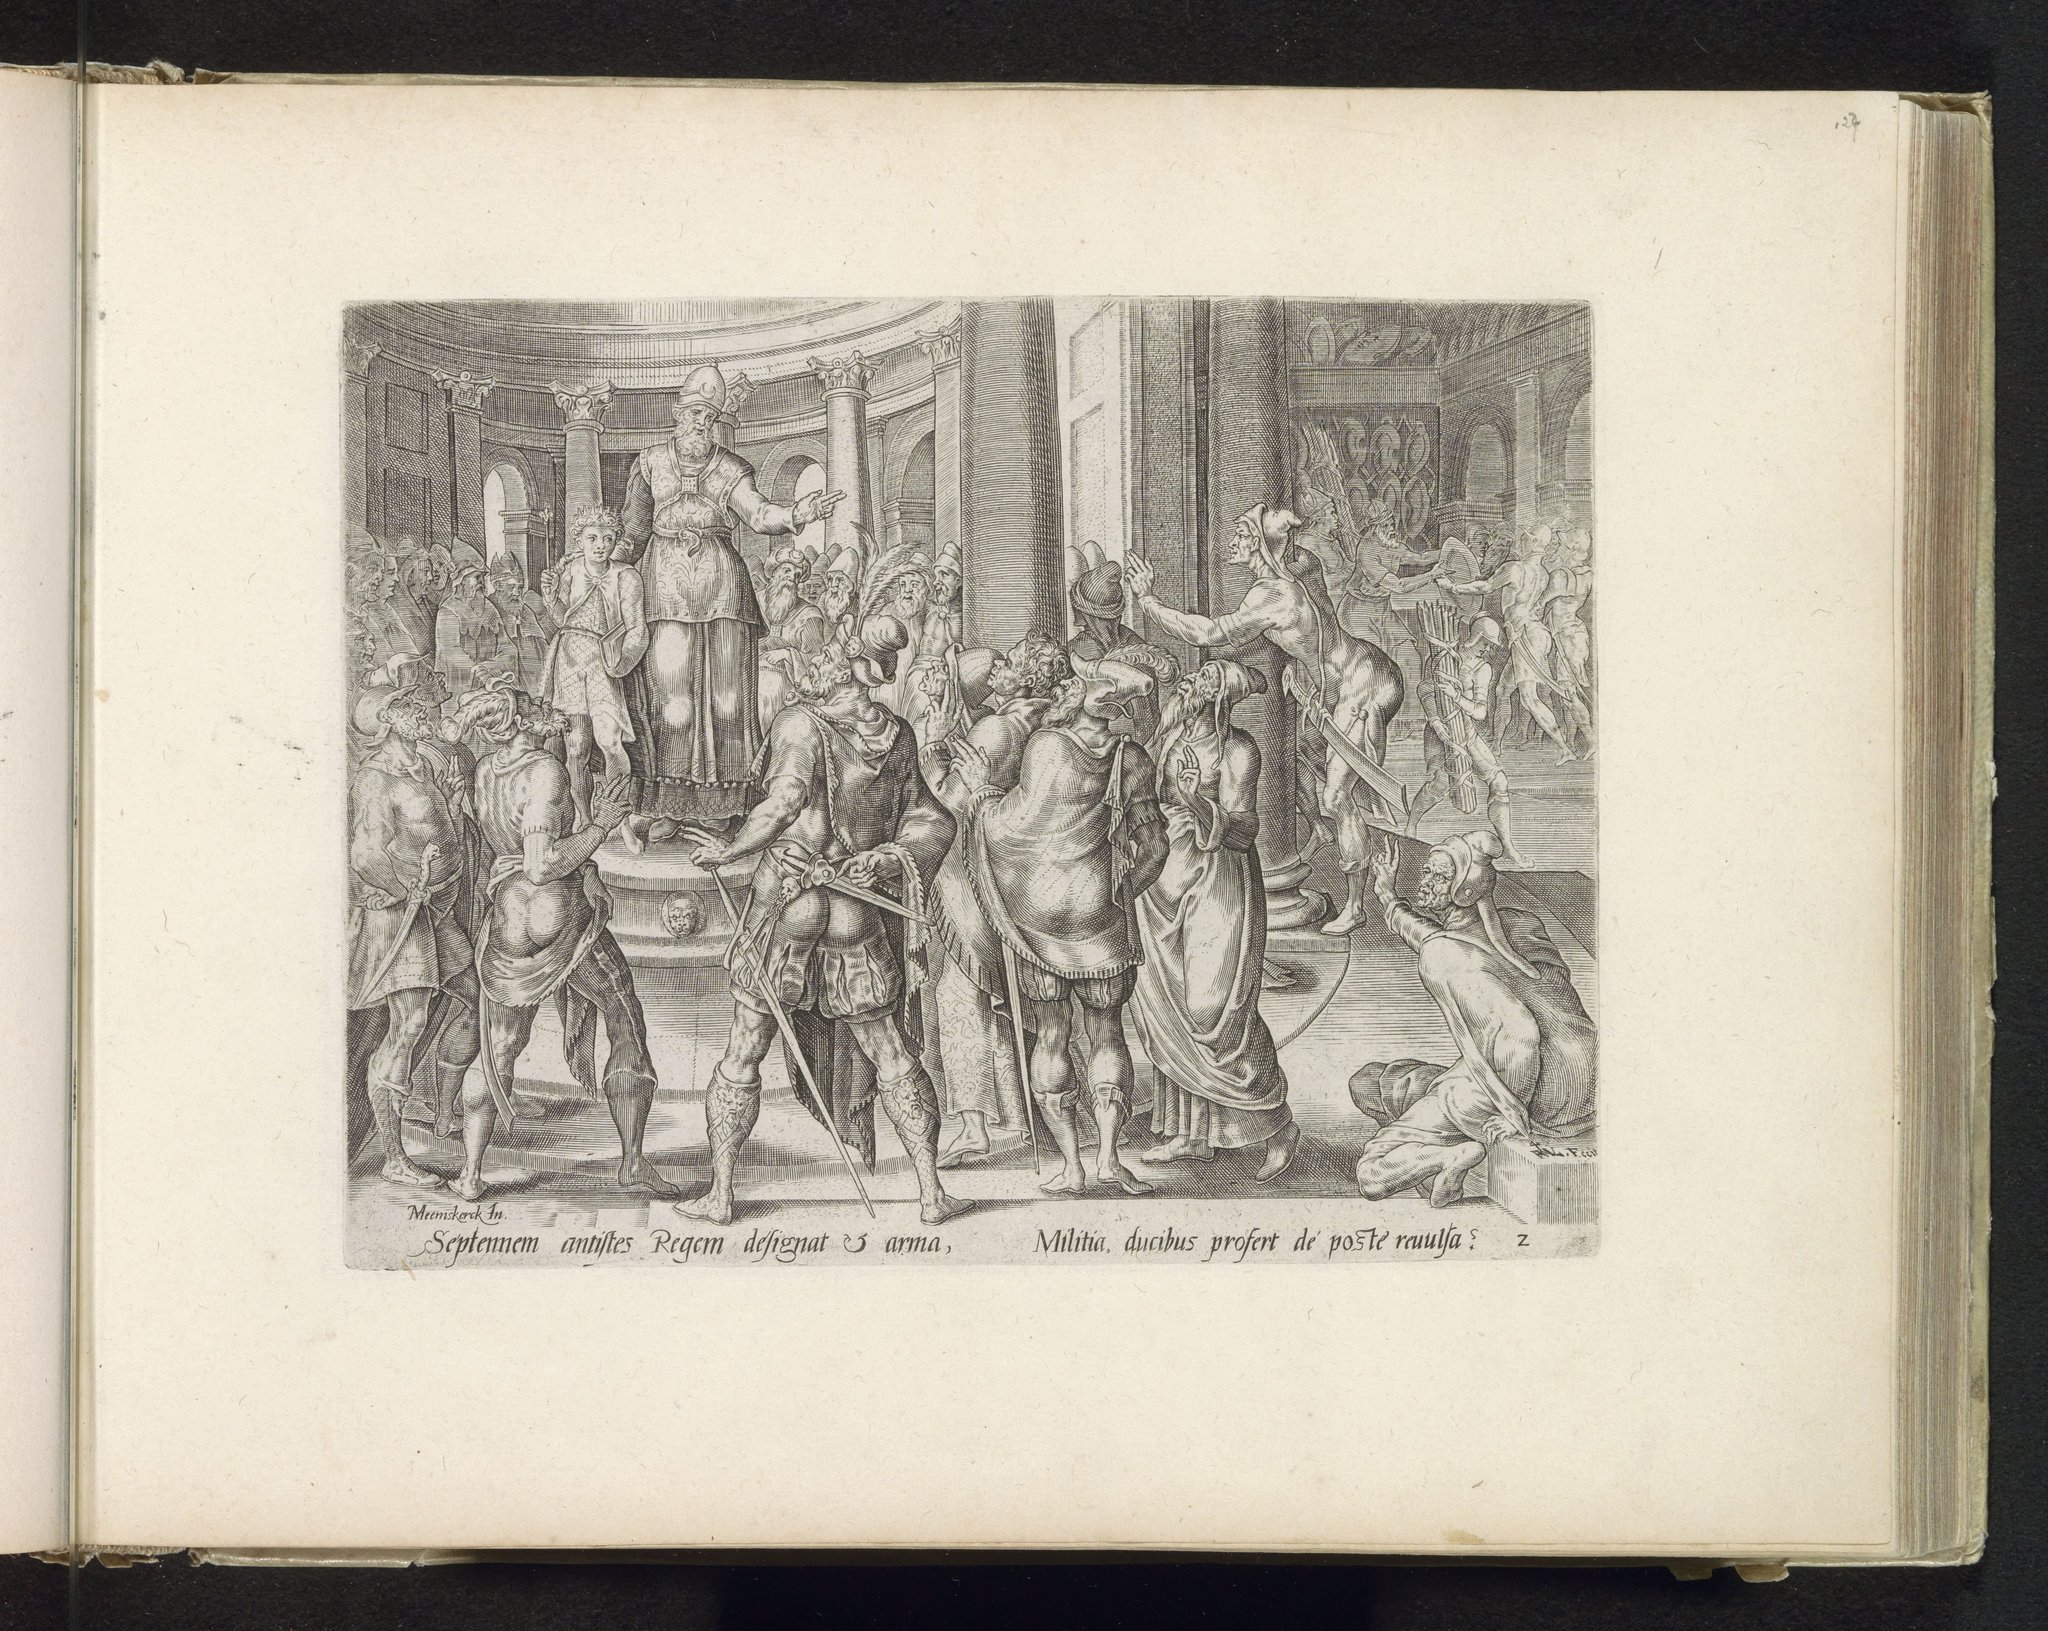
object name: album leaf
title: Joas aan het leger gepresenteerd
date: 1585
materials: paper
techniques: engraving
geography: antwerp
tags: jehoiada gathers a group of soldiers, presents joash to them and persuades them to swear allegiance to him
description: Op een verhoging in de tempel stelt de hogepriester koning Joas voor aan de koninklijke garde. De mannen zweren trouw aan de koning. Rechts achteraan worden speren en de schilden uitgedeeld. Onderaan in de marge een vers in het Latijn over de voorstelling. Deze prent maakt deel uit van een album.